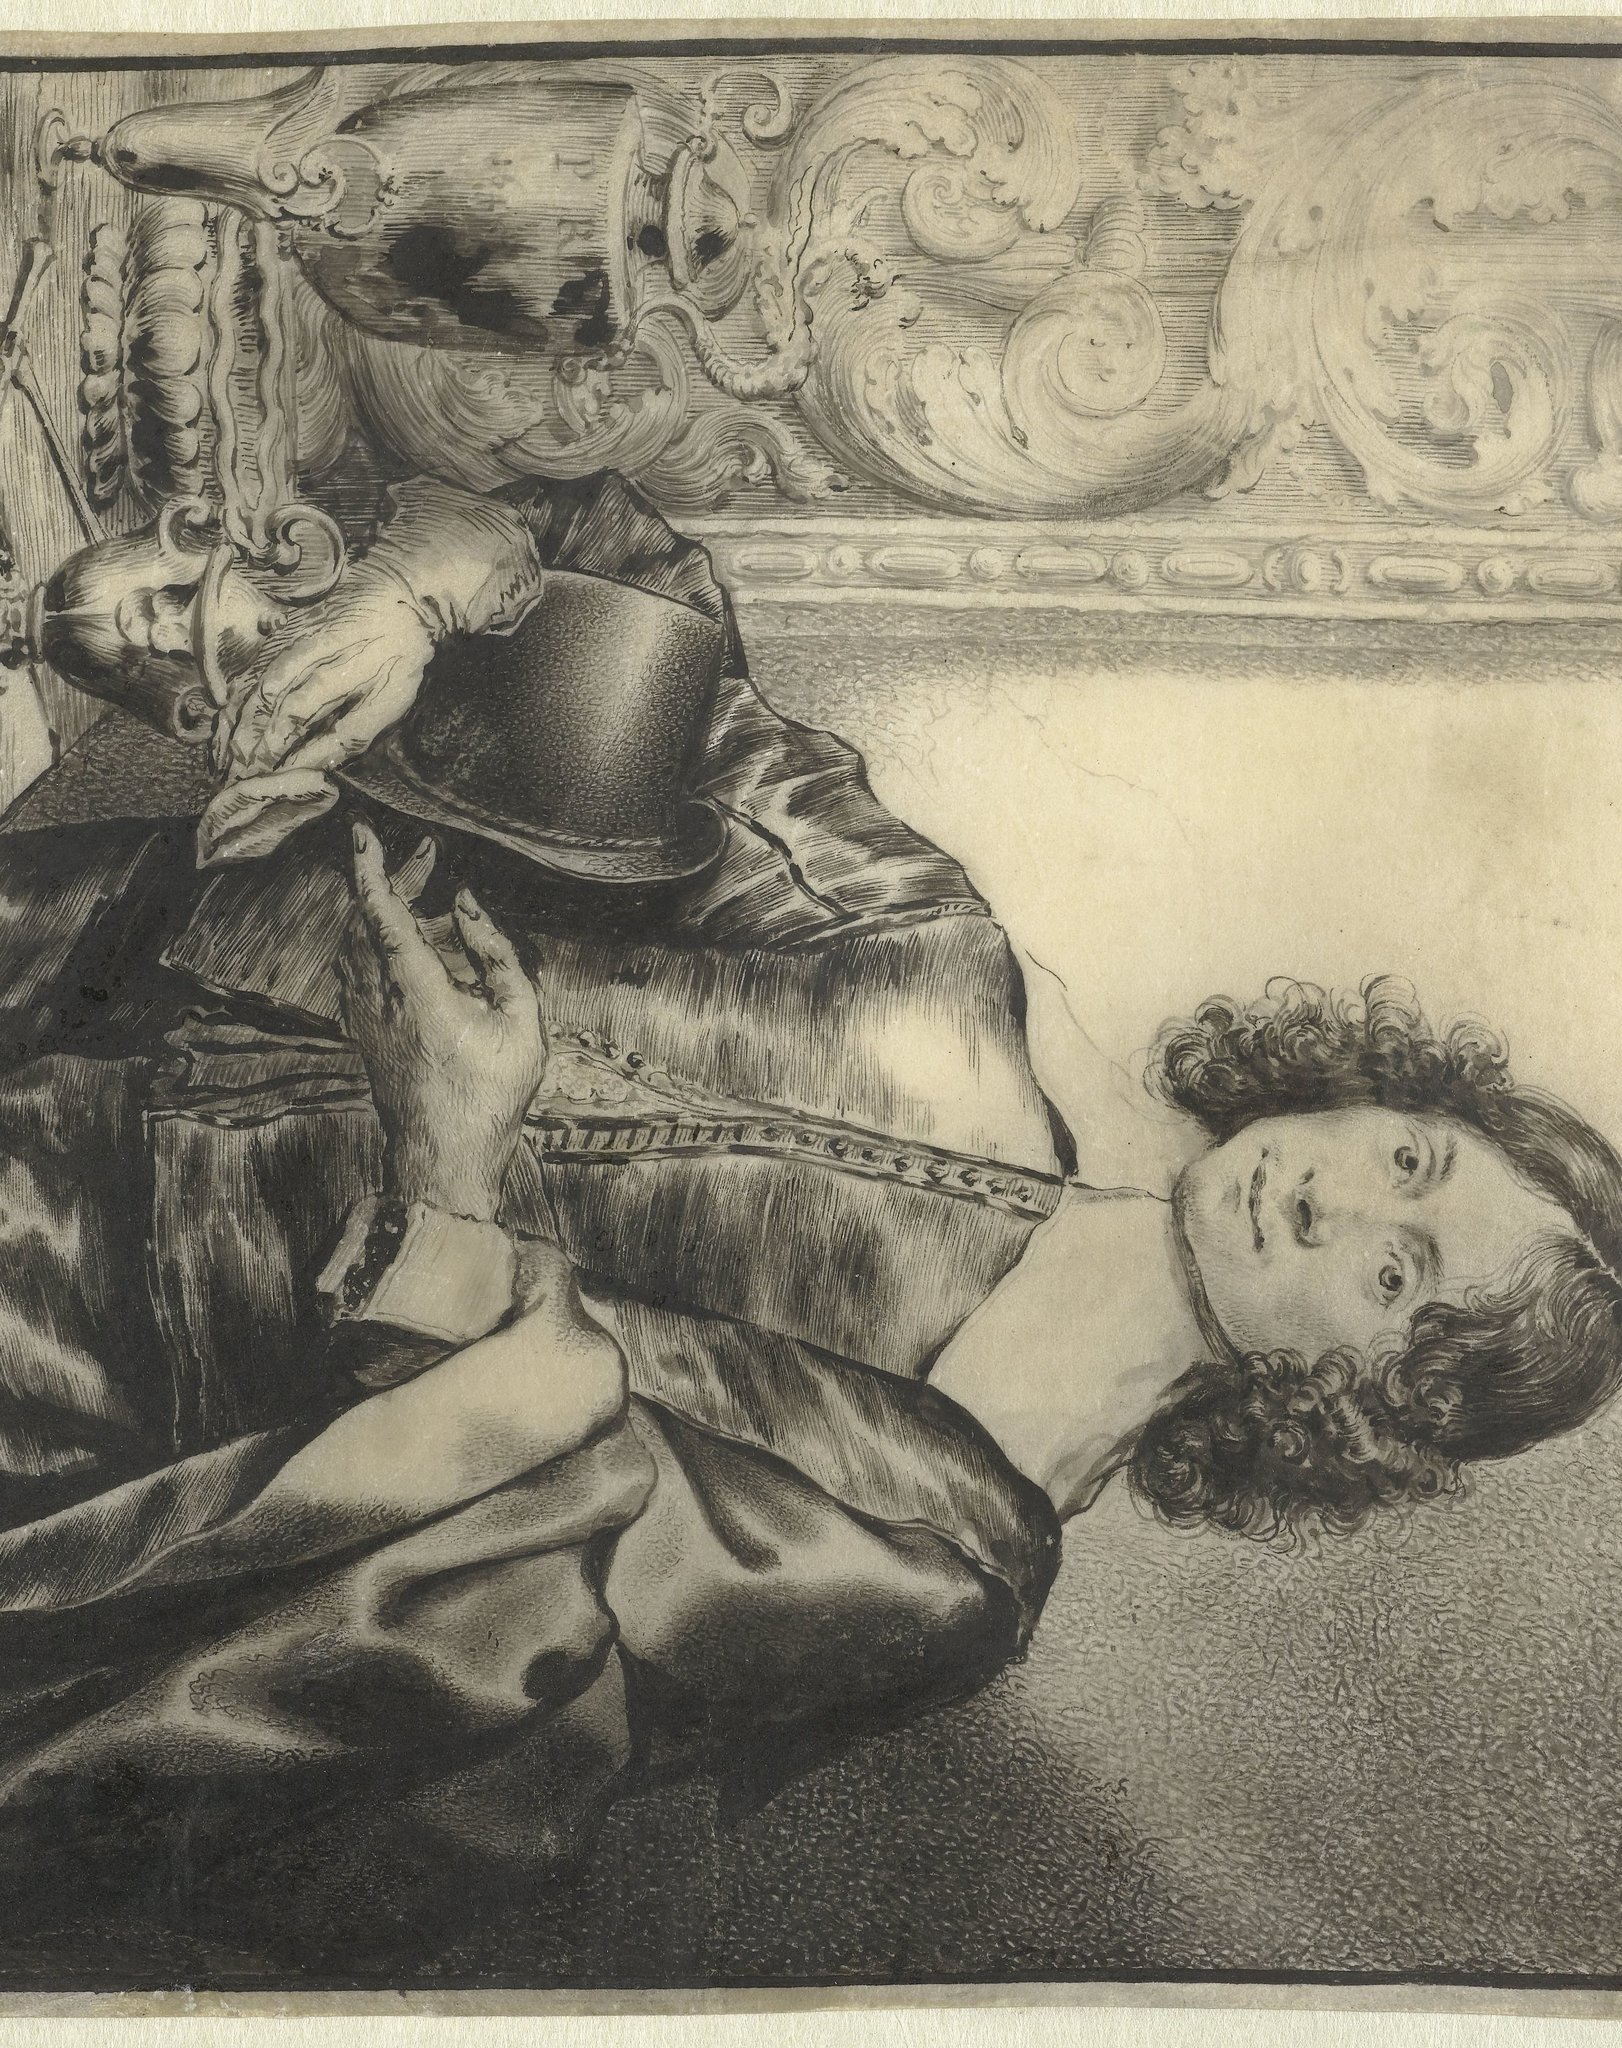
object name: drawing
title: Portret van een edelsmid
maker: pieter rottermondt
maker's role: draughtsman, print maker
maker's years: -1706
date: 1645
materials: ink, parchment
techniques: brush, pen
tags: amsterdam, johannes lutma (1624-1689), historical persons, jeweller, goldsmith, silversmith, portrait, self-portrait of craftsman in applied arts, work of applied art (+ precious metals ~ arts)